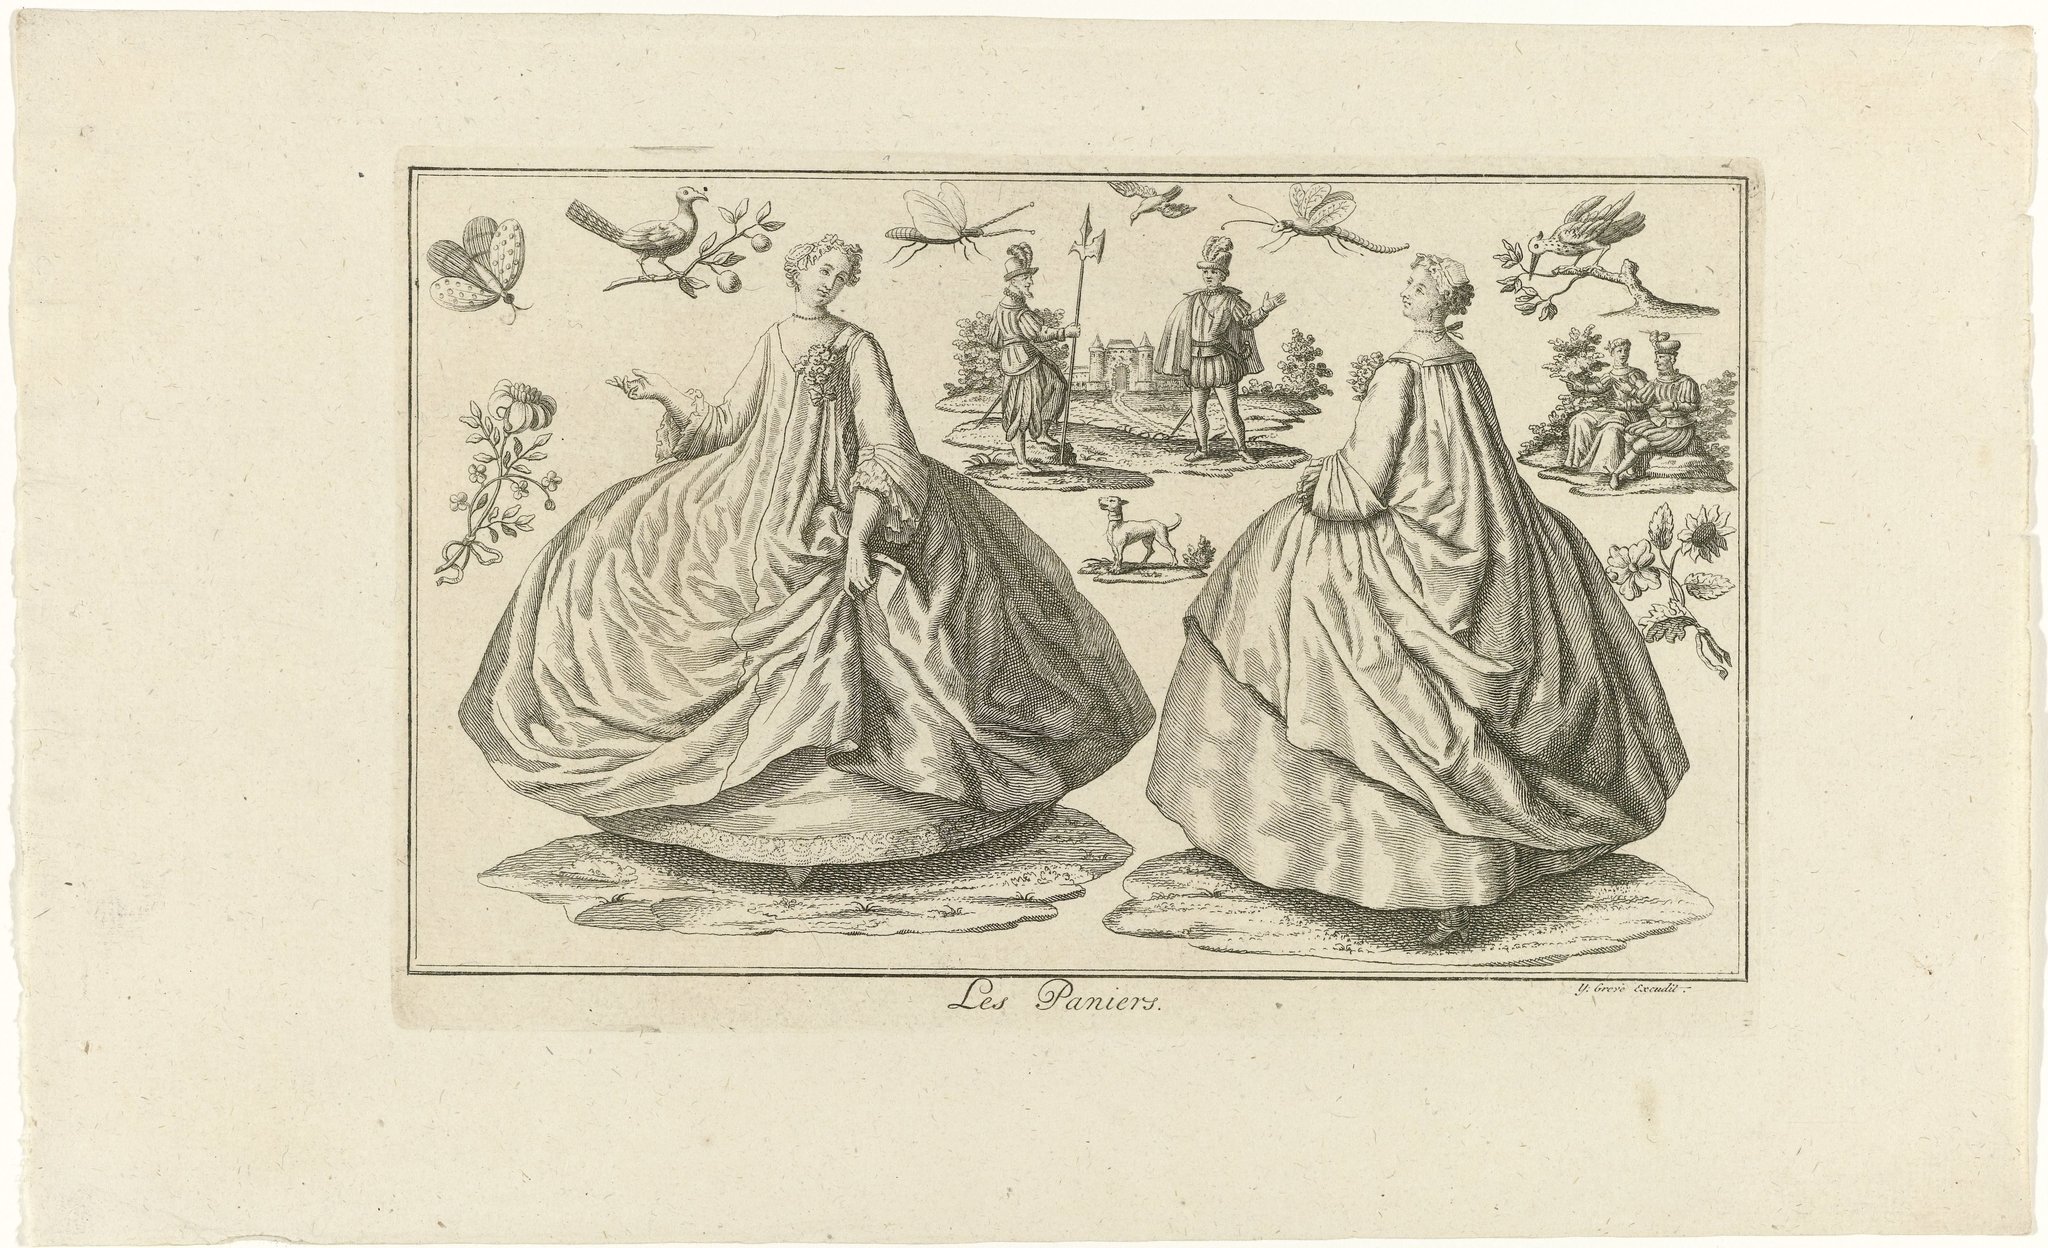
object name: costume print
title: Les Paniers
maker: isaac greve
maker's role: publisher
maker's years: 1677-1757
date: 1729-1730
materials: paper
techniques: etching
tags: dress, gown: robe volante (+ women's clothes), skirt (underskirt) (+ women's clothes), dress, gown (robe a paniers) (+ women's clothes), fashion plates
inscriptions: title: ‘Les Paniers’, address: ‘Y. Greve Excudit’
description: Twee vrouwen in 'Paniers'. Links van voren, rechts van achteren gezien. Mannenfiguren en insecten op de achtergrond. Uit reeks van kostuumprenten. 6 stuks. Kopie naar Hérisset, met toegevoegde achtergrond: figuren, planten, vogels en insecten.